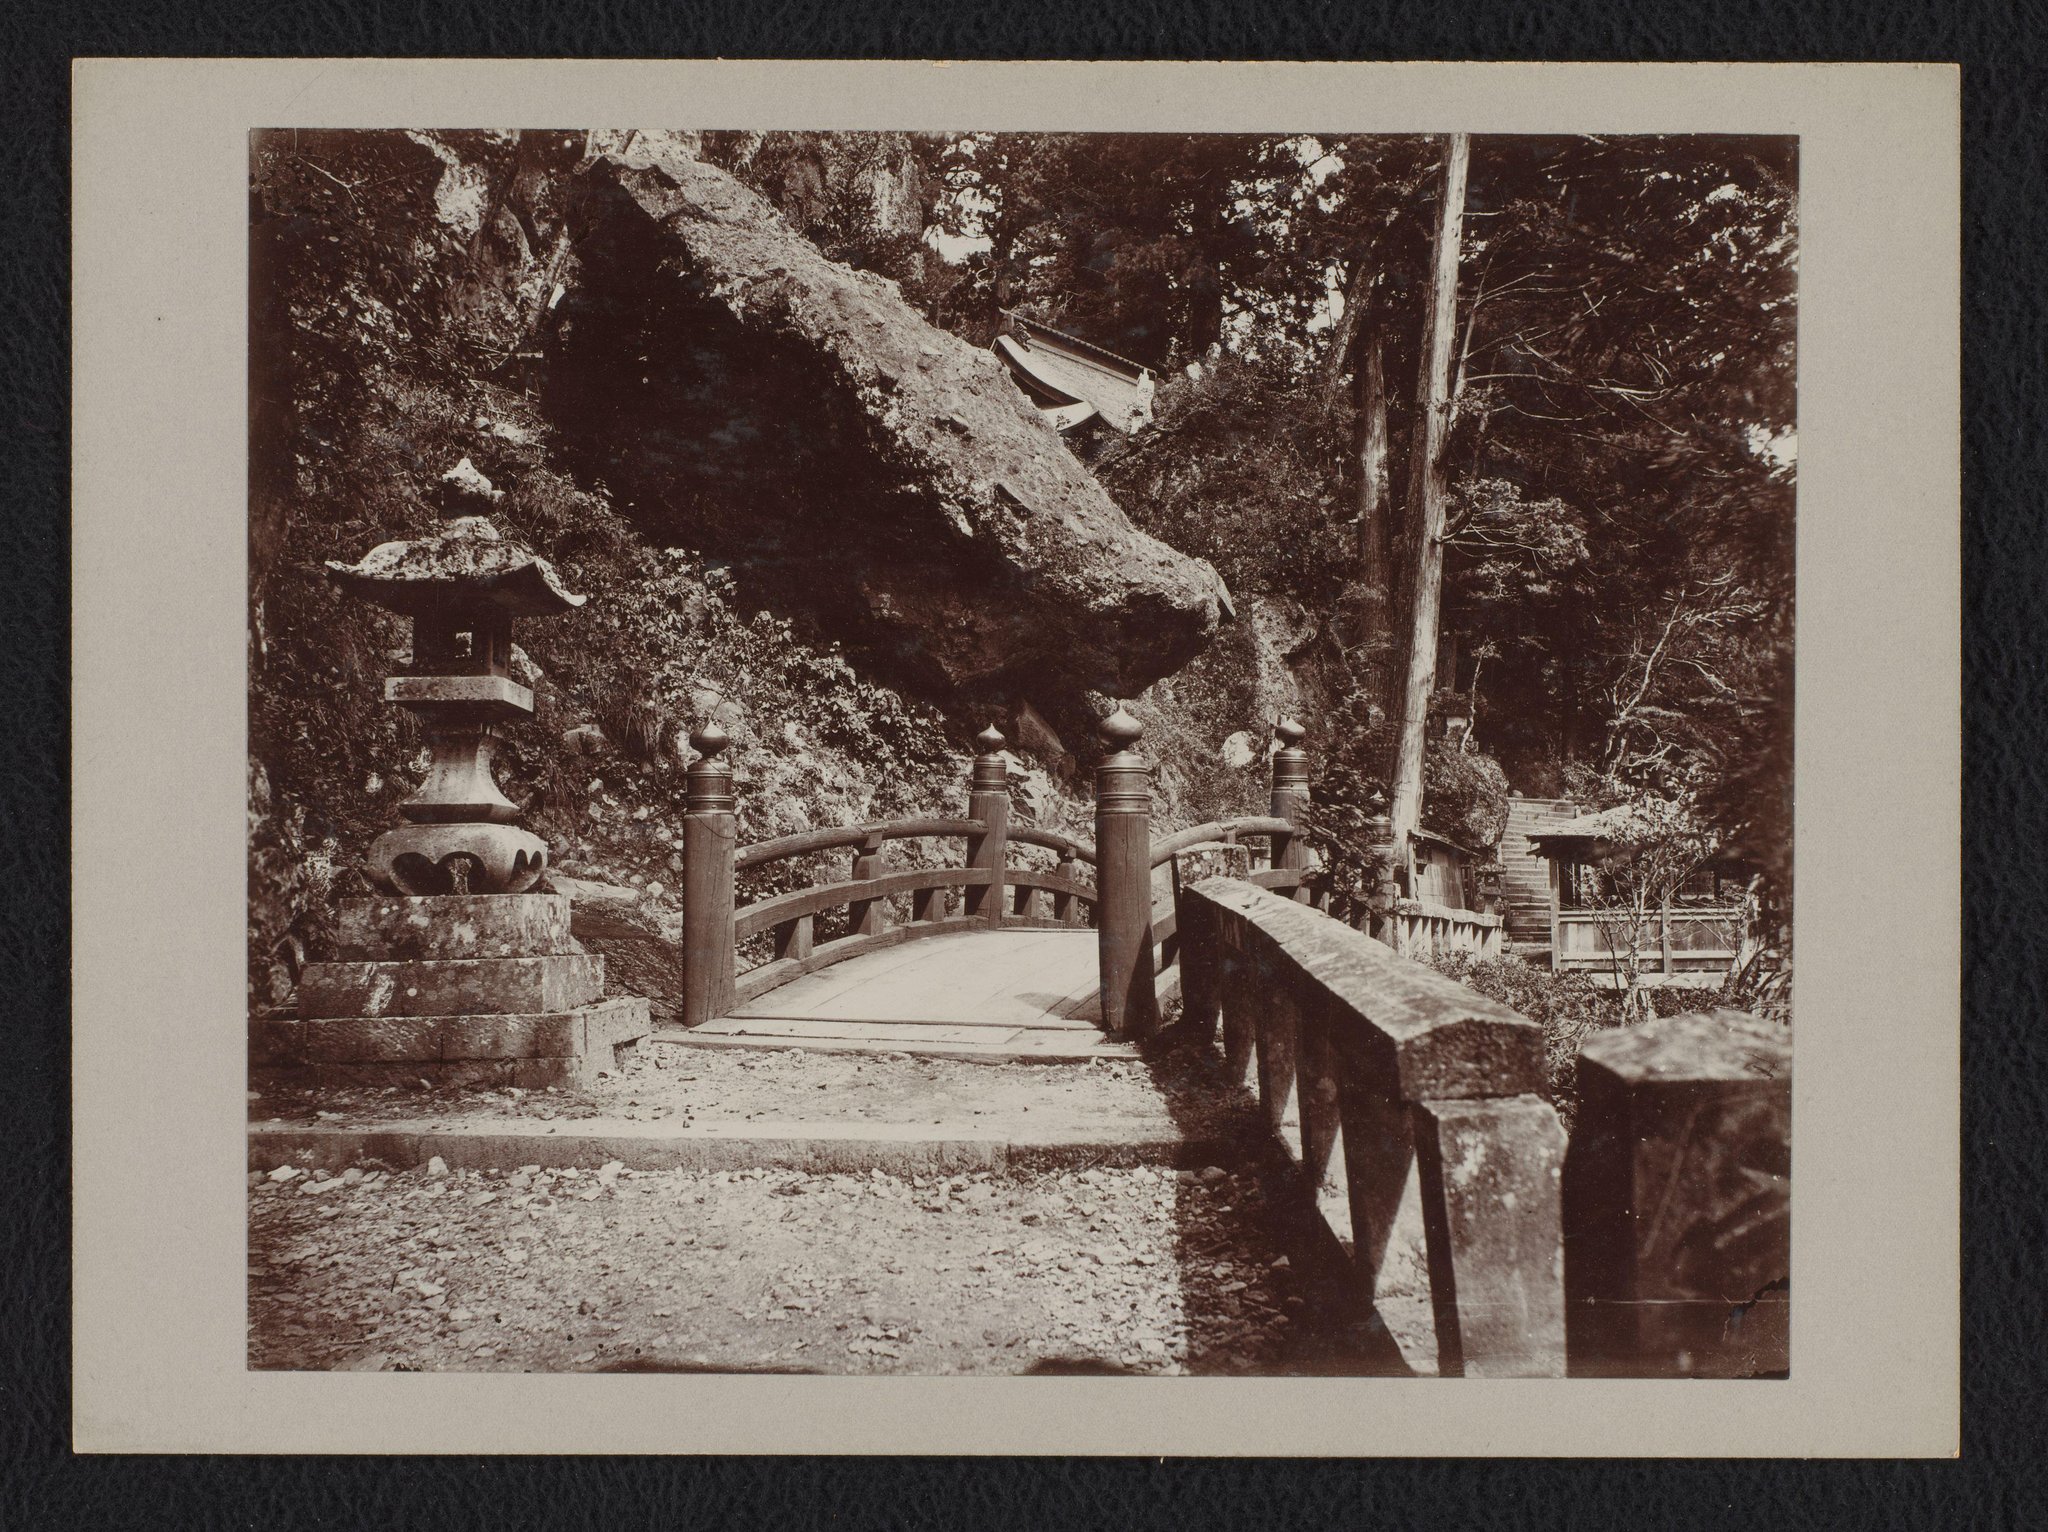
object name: photograph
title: Ingang van de Haruna tempel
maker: Anonymous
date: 1895-1915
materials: cardboard, photographic support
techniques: collodion silver print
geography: haruna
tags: haruna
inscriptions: annotation: ‘46. Ingang Haruna tempel.’